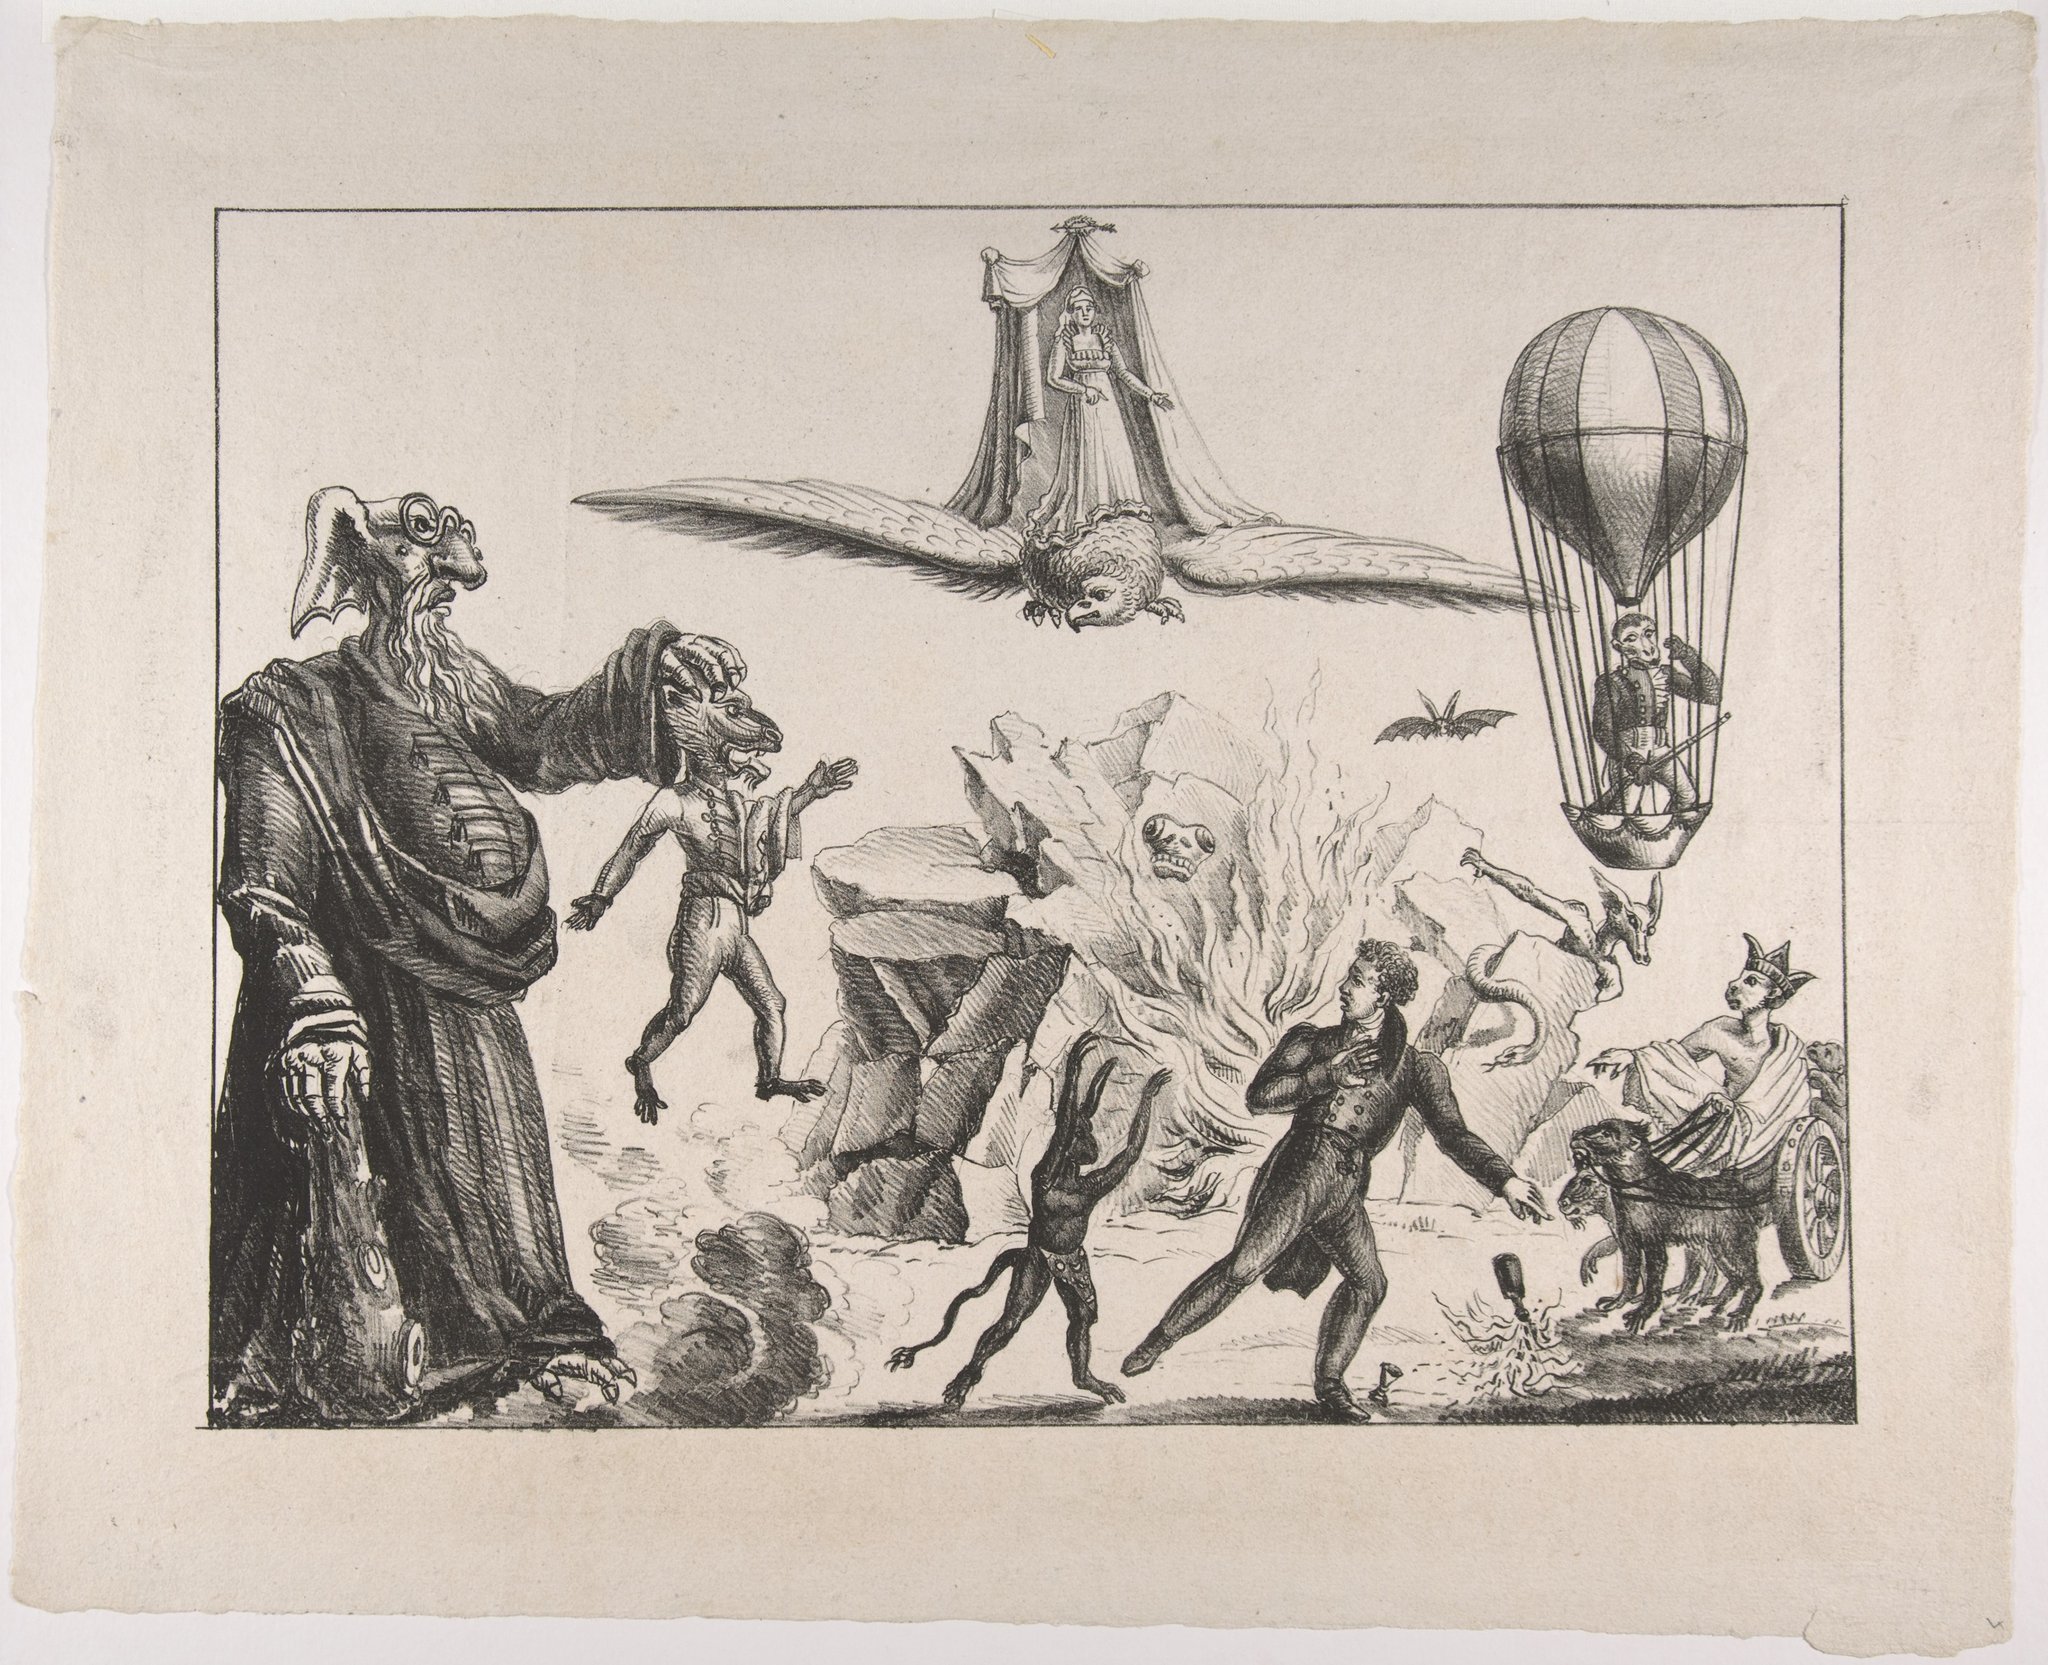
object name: print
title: Monsters, Monkeys, and Men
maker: anonymous, french, austrian or german, second decade19th century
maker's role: artist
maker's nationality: french, austrian or german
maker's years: 1820-1840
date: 1820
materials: paper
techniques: lithograph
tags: birds,men,women,monsters,monkeys